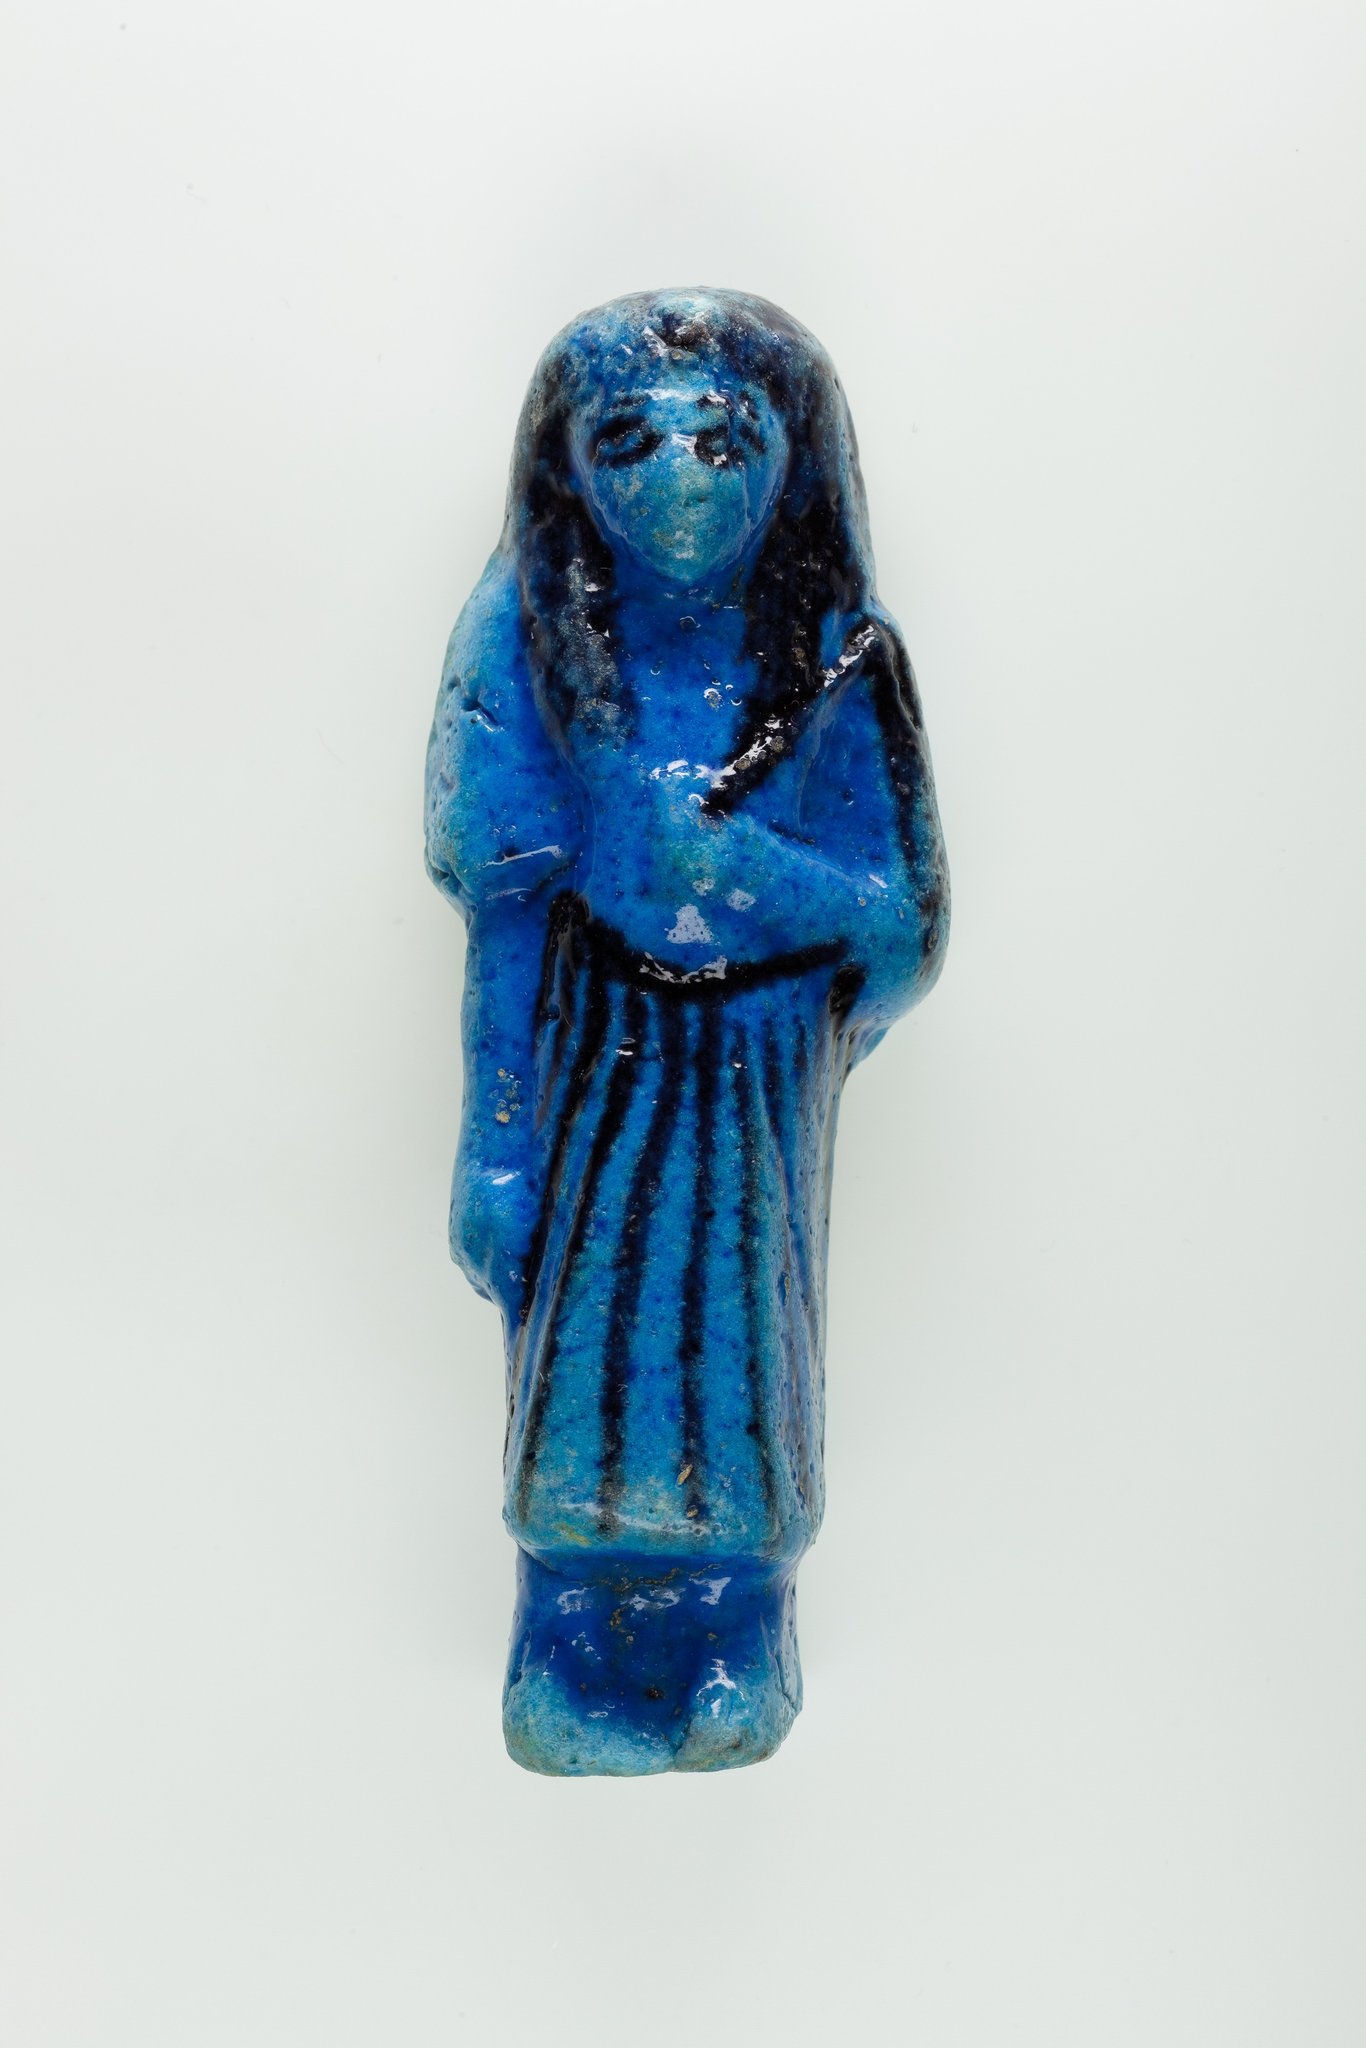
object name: shabti, overseer, nauny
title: Overseer Shabti of Nauny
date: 1050 BCE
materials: faience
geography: egypt